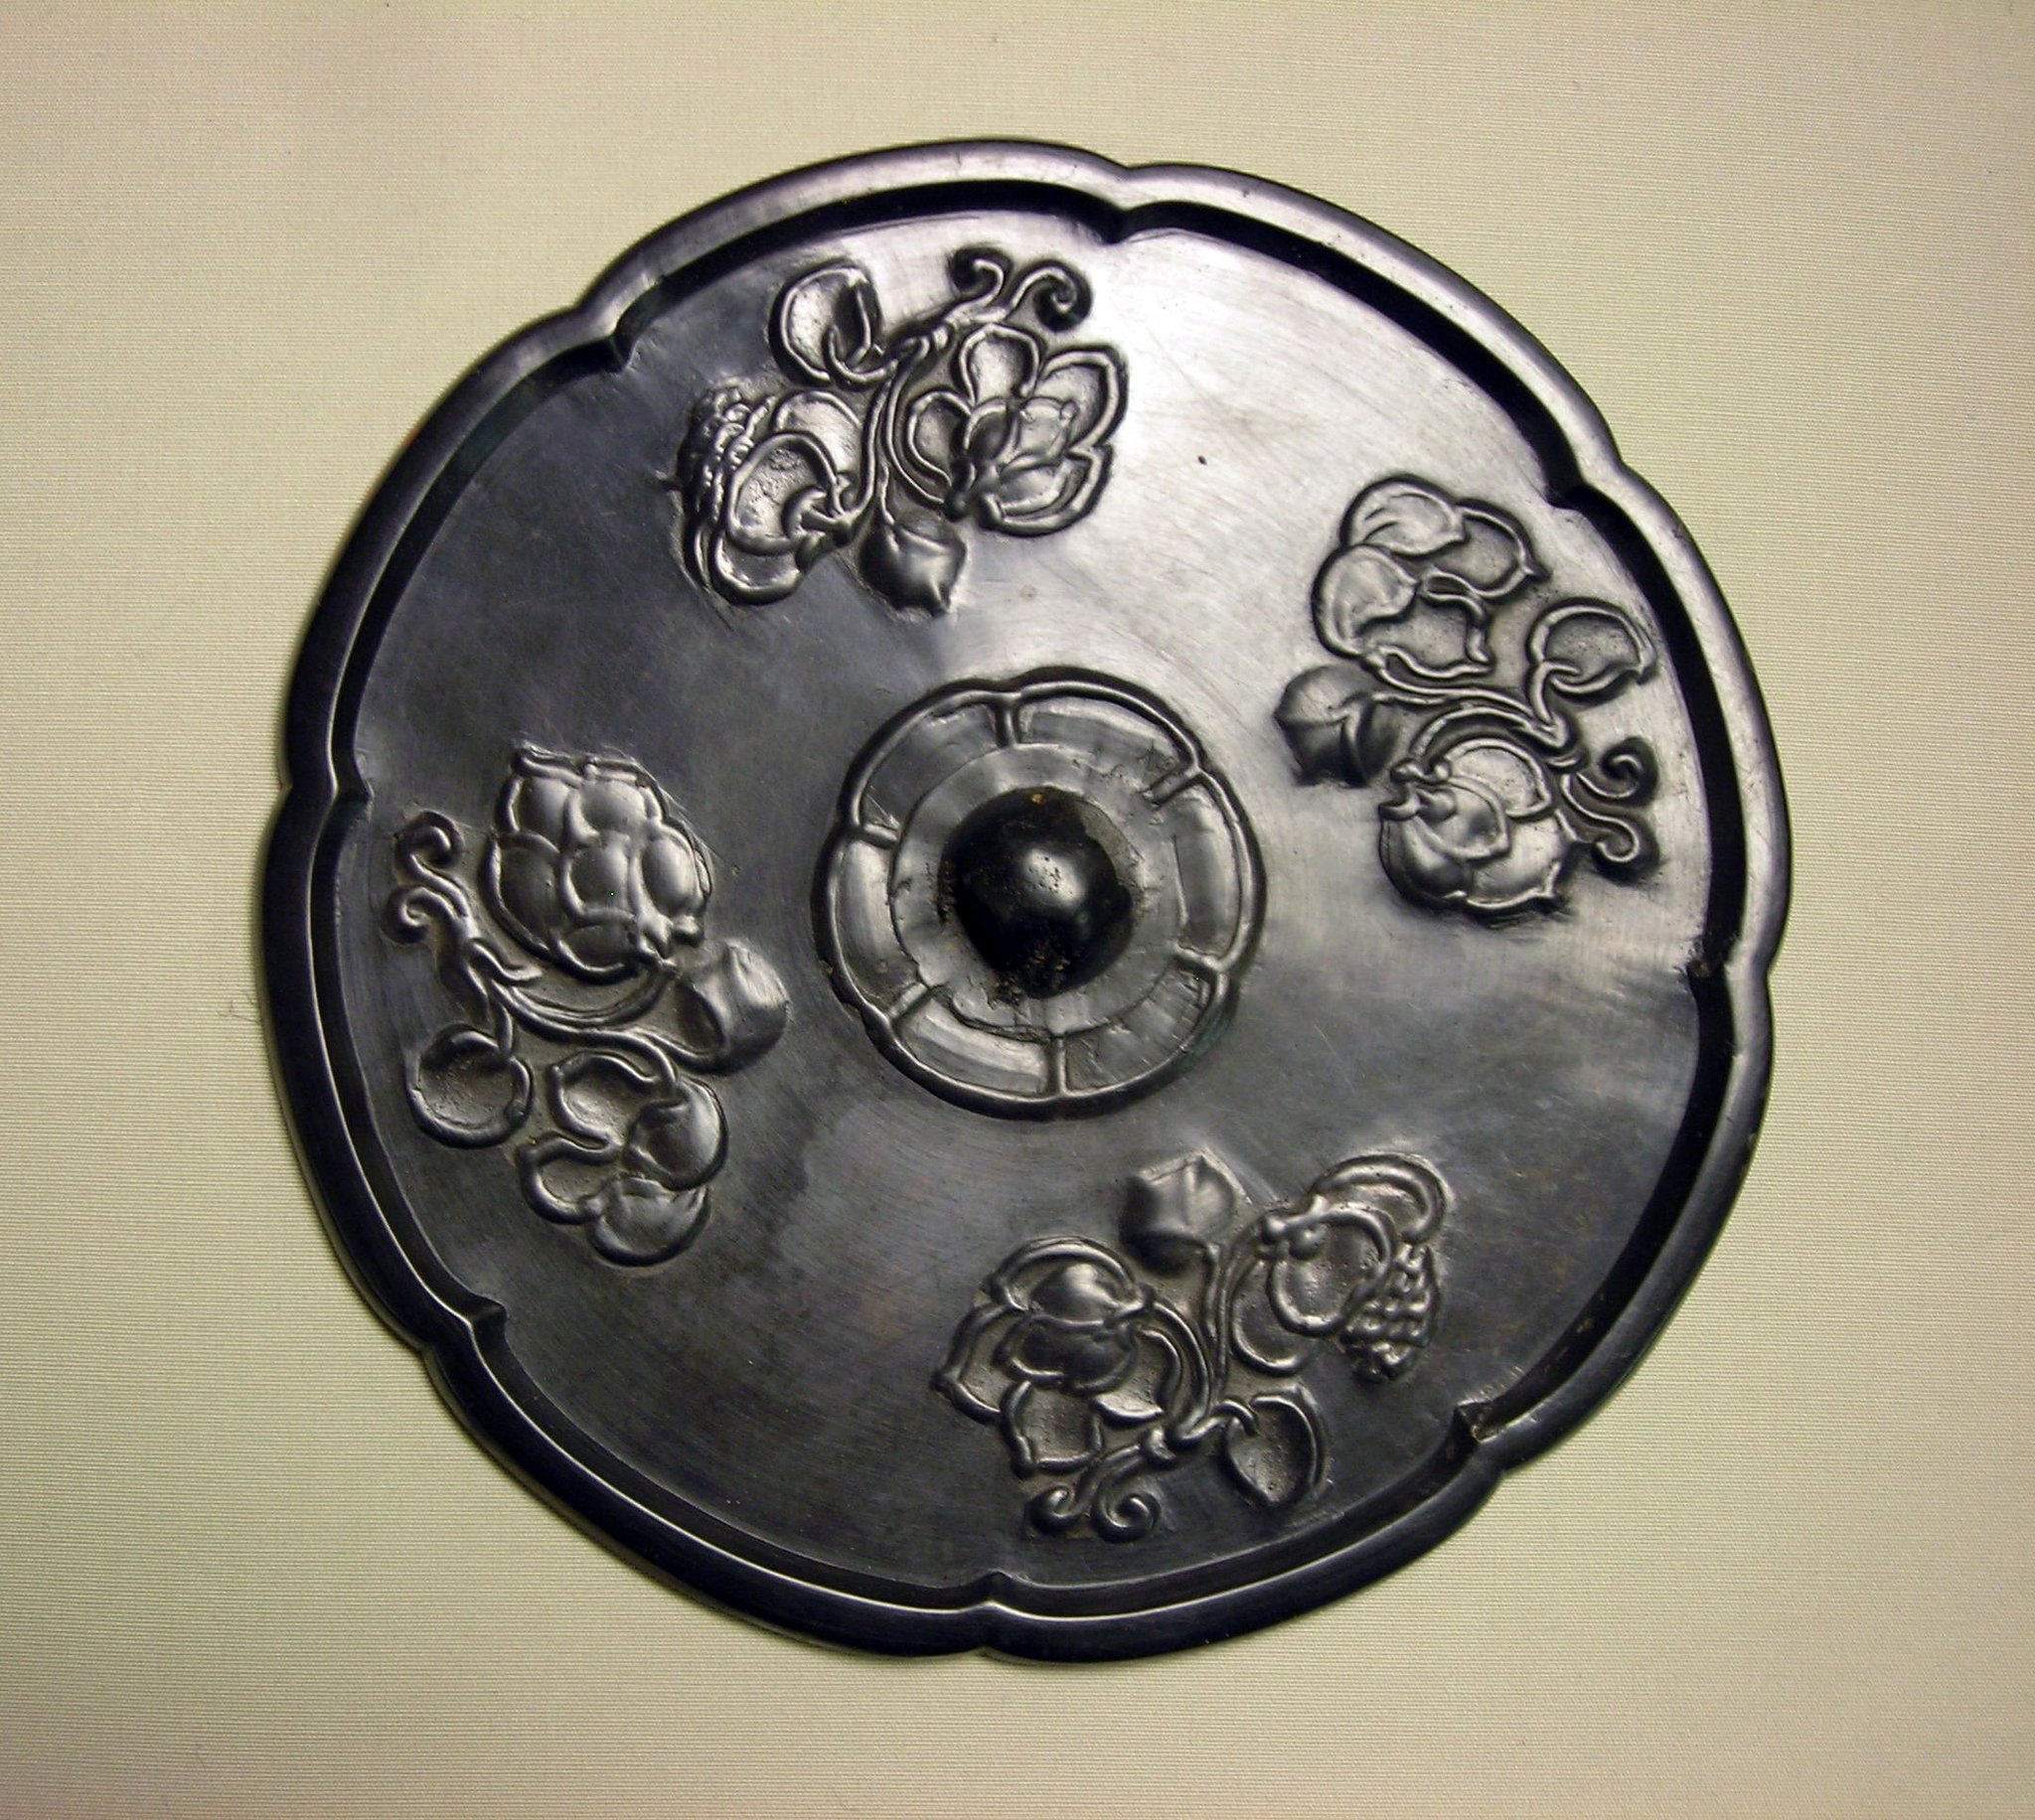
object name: mirror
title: Mirror with floral designs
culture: chinese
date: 701-800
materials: bronze, patina